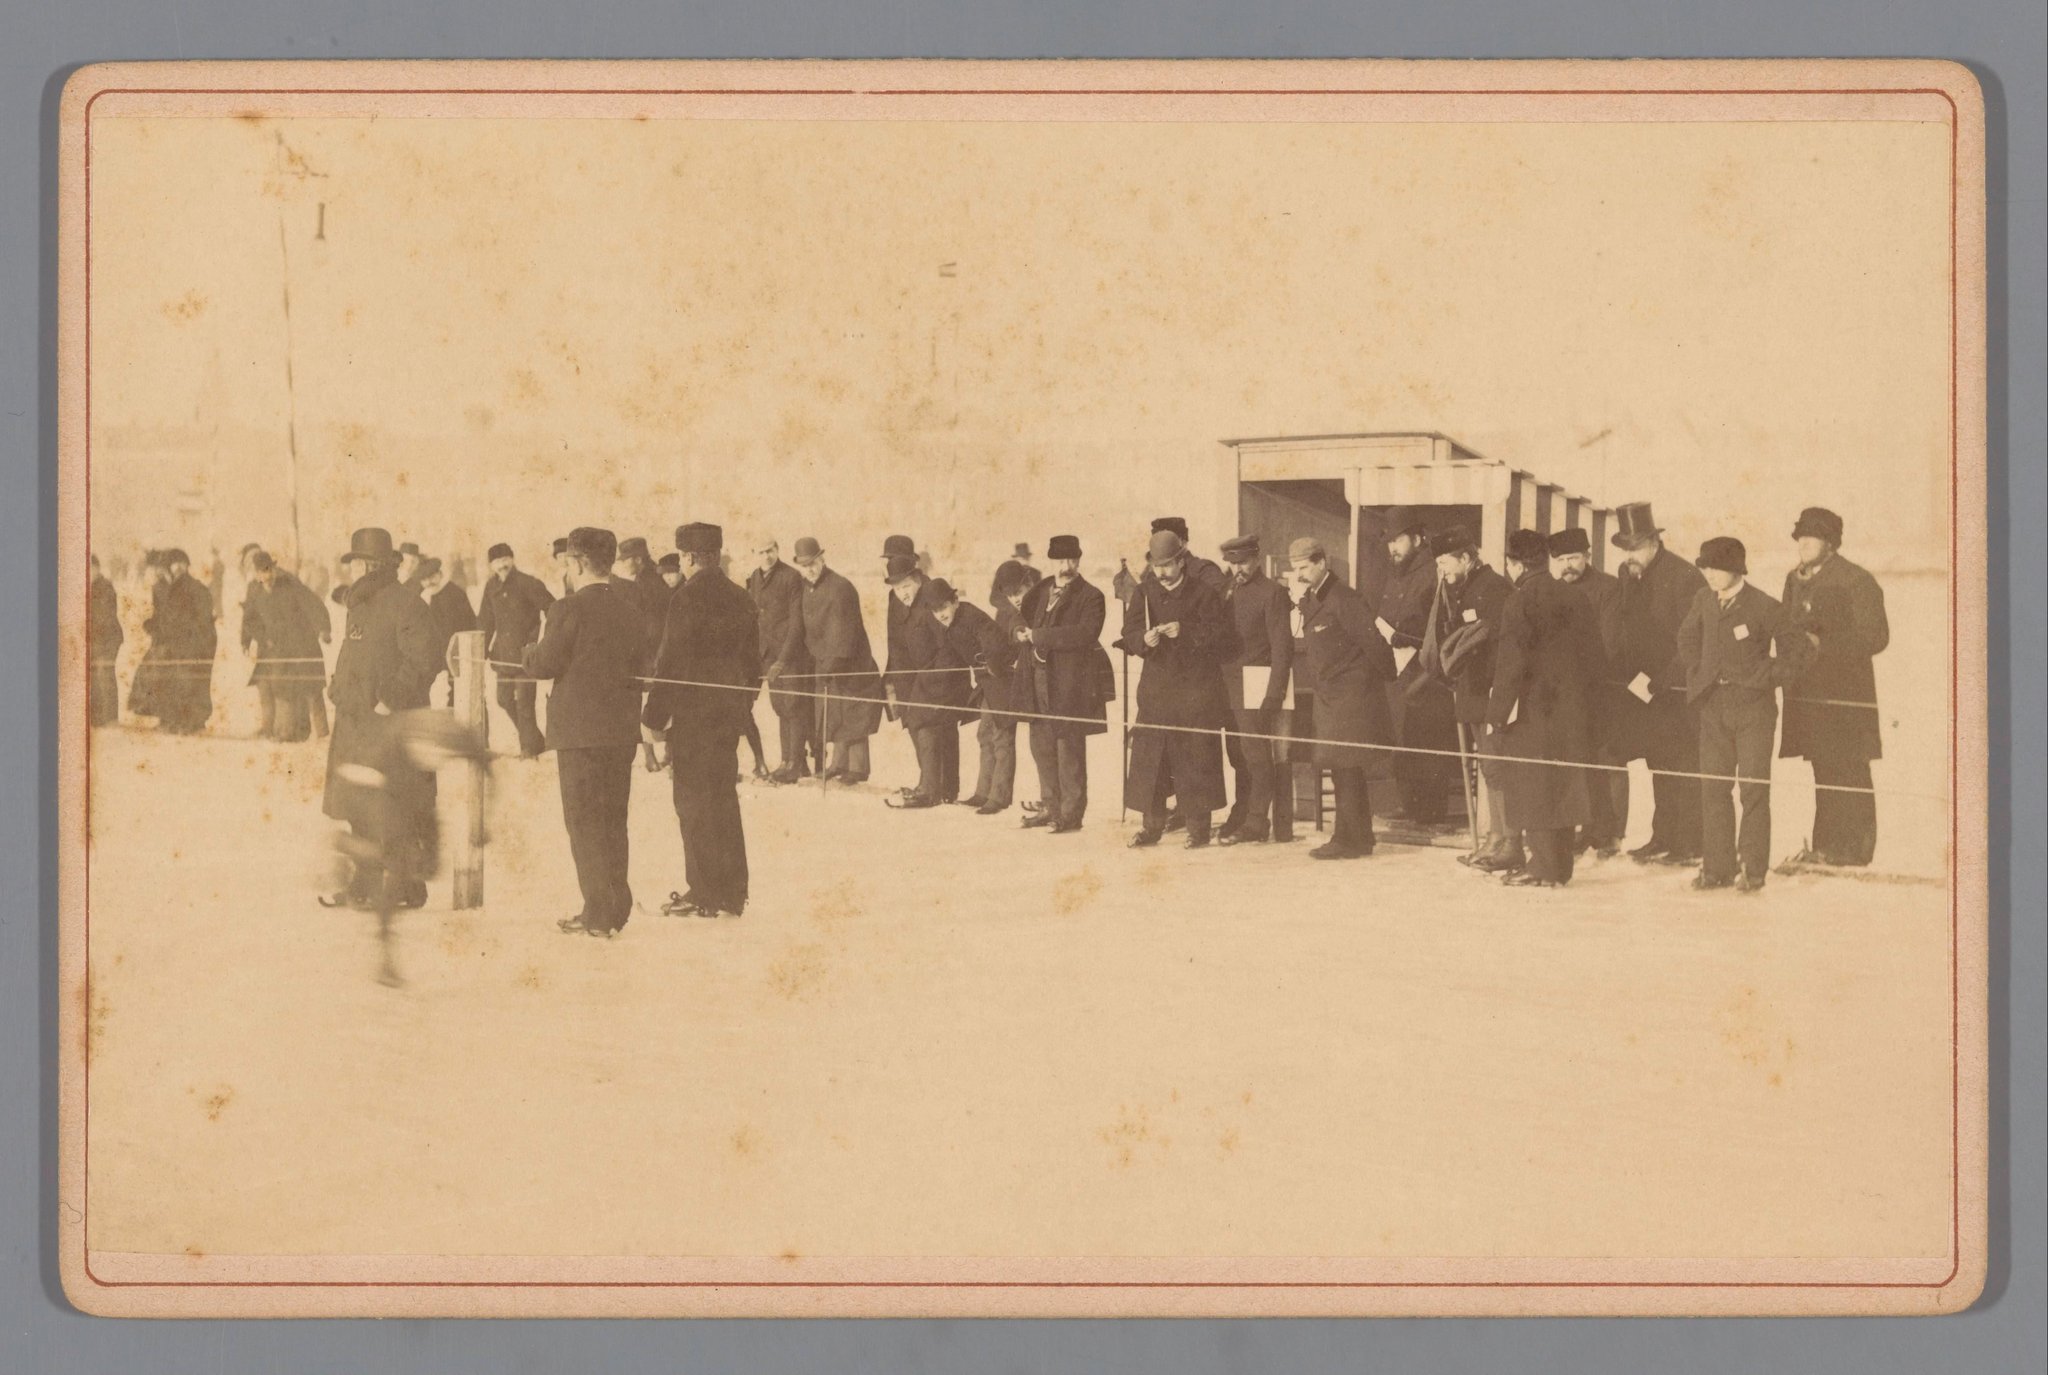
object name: photograph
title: Groep mannen langs de baan van de Amsterdamse IJsclub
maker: sigmund löw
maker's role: publisher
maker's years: 1845-1920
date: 1891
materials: cardboard, photographic support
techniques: albumen print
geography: amsterdam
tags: adult man (+ more than eight persons), skates (winter sports), amsterdam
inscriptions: inscription: ‘Eera Diploma Donaueschingen 1874/ ZILVEREN MEDAILLE KARLSRUHE 1877/ Photographie Artistique/ &/ Kunsthandel/ van/ S. Herz Amsterdam./ Heerengracht 80 & Heerenstraat 4.’, number: ‘No 1’